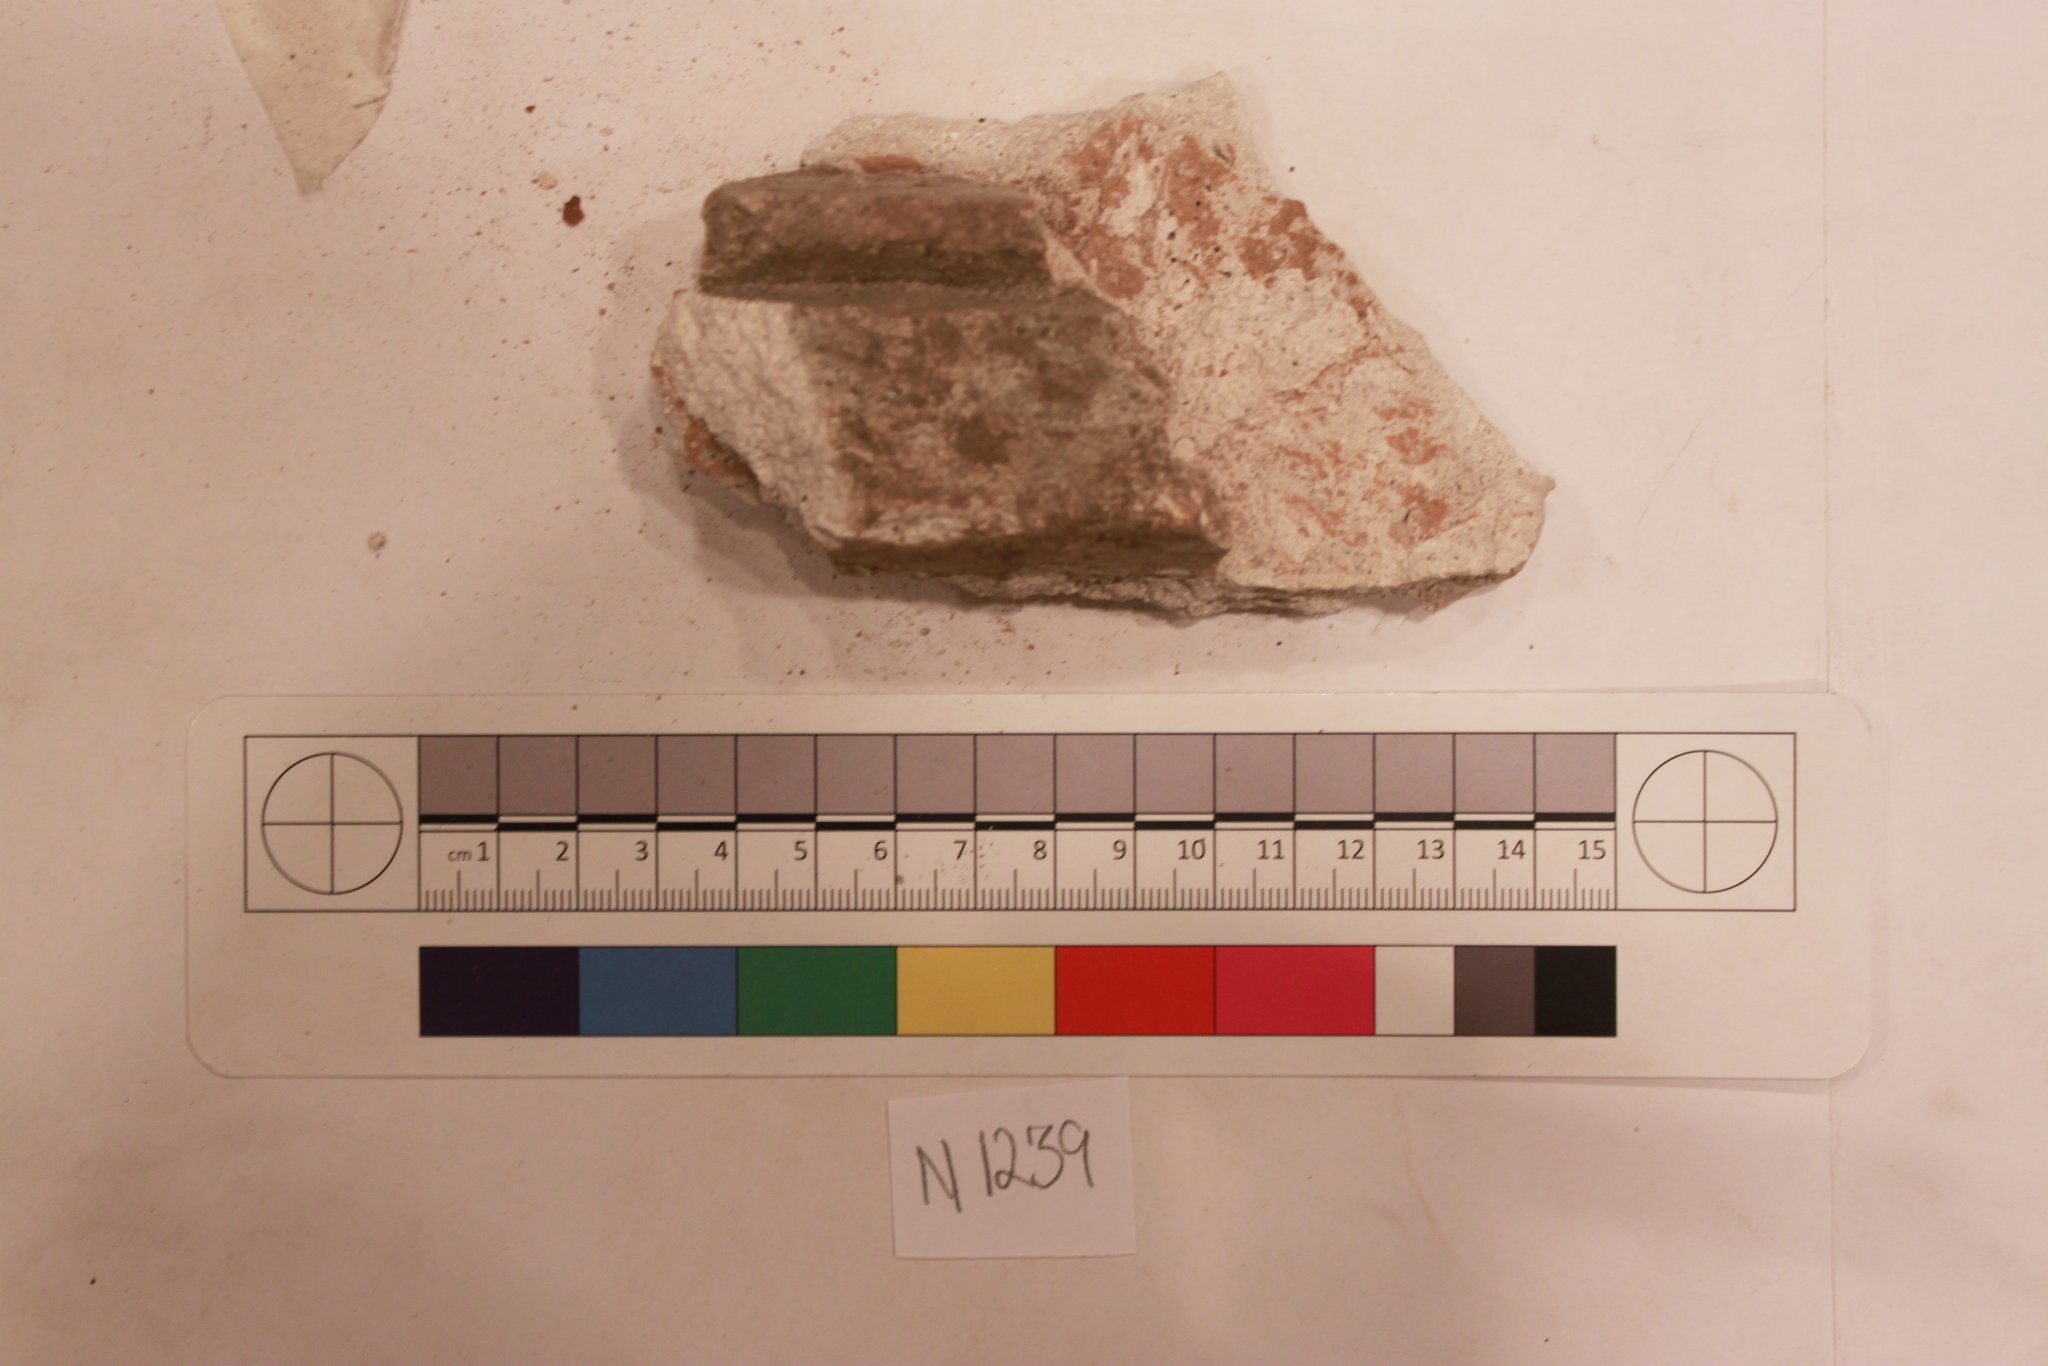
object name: fragment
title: Stucco Fragment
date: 701-1200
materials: plaster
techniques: carving, painting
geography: iran